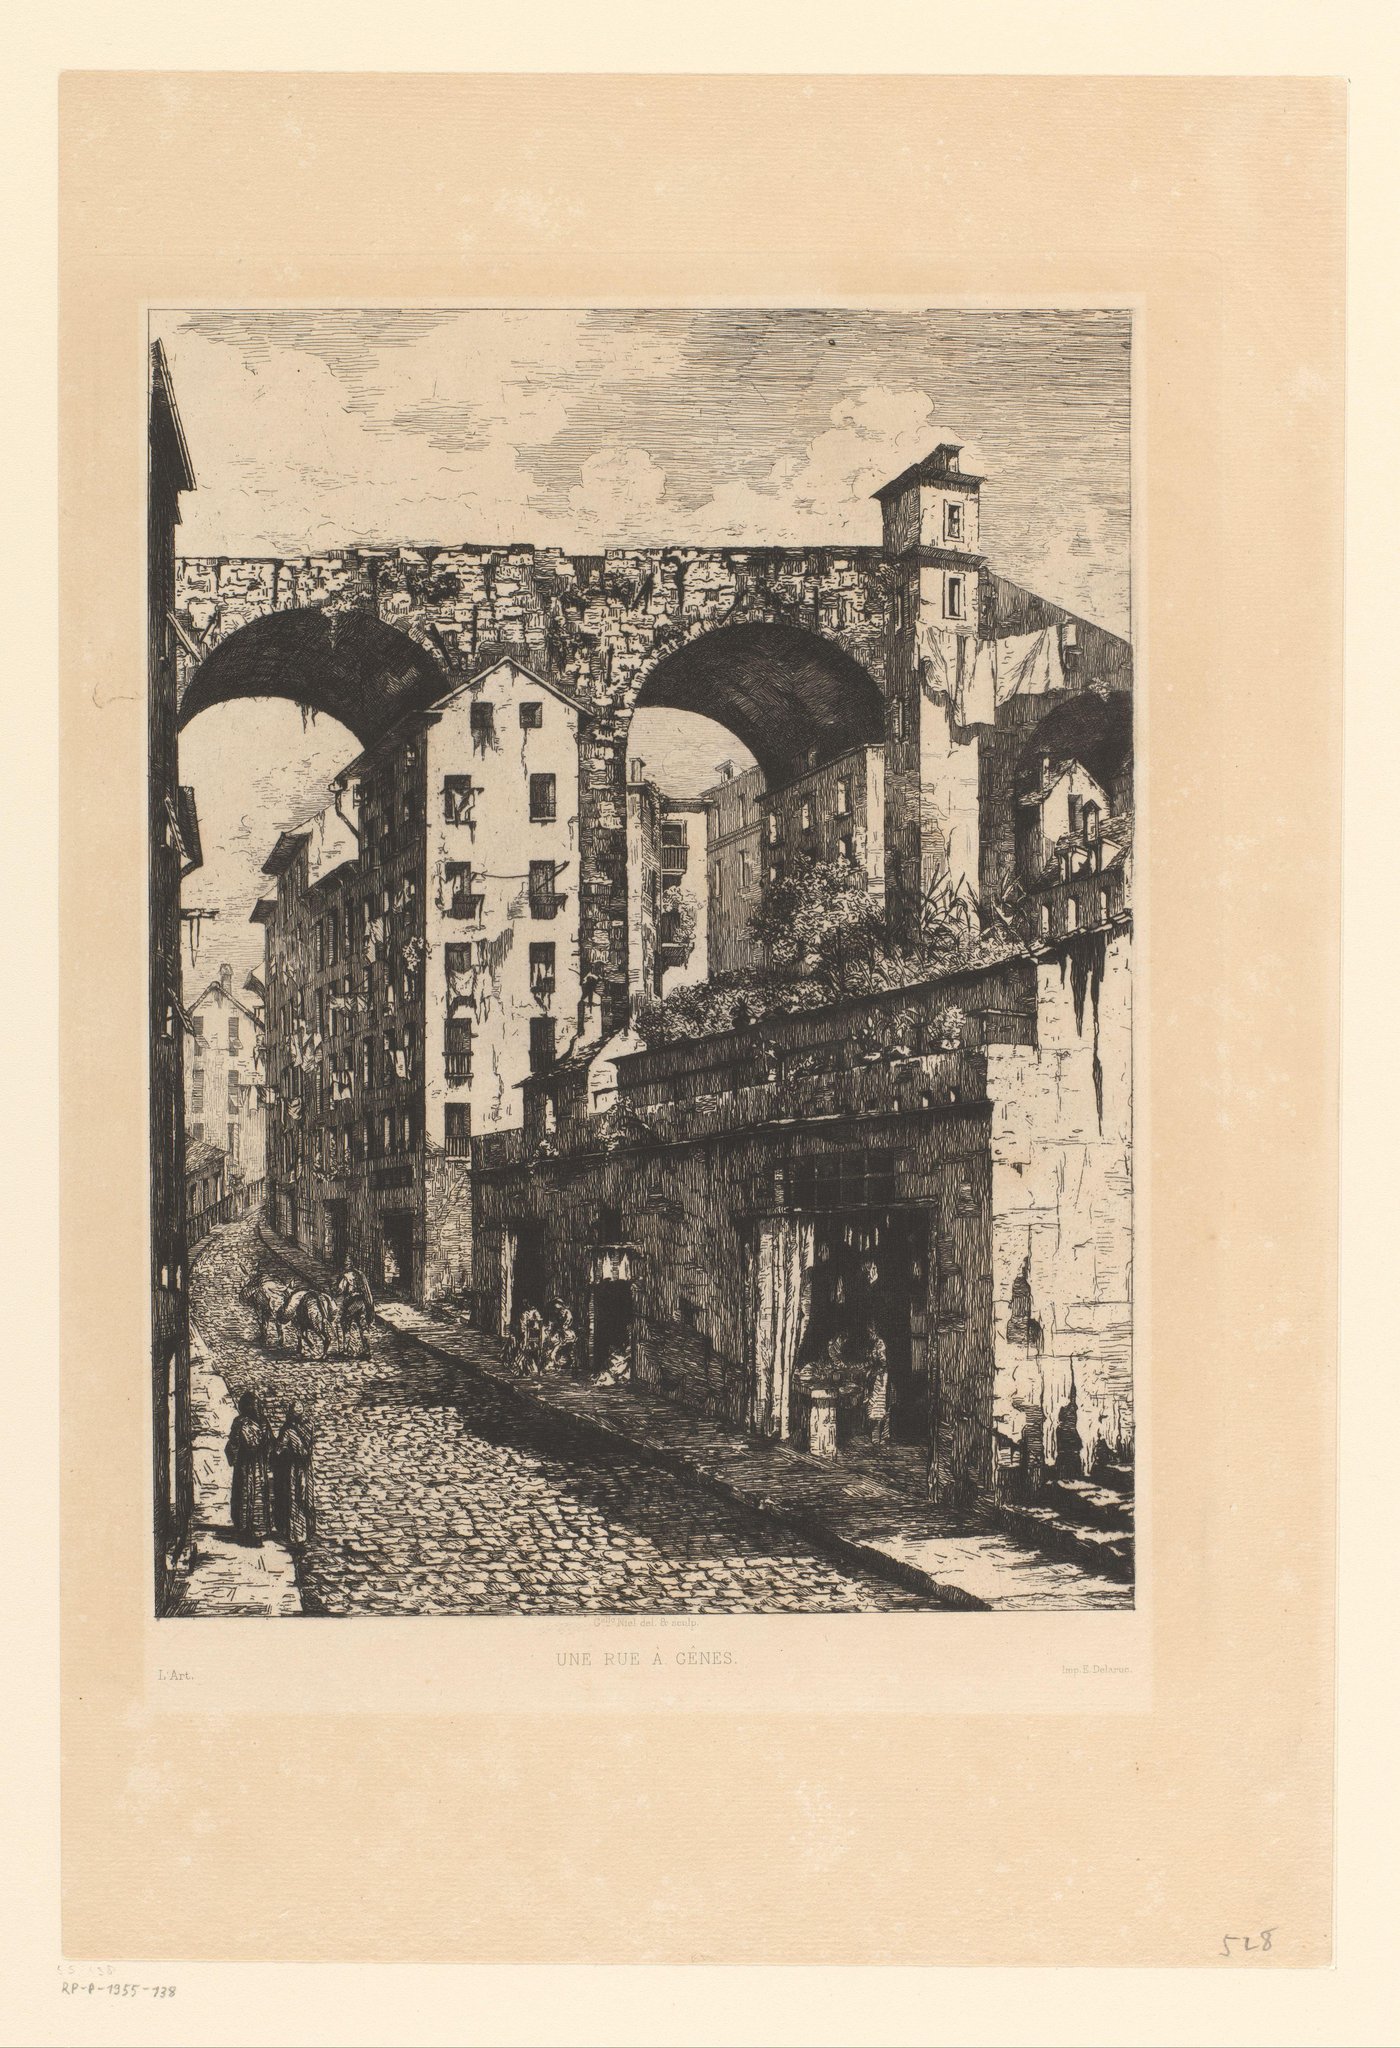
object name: print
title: Straatgezicht in Gênes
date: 1850-1940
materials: paper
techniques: drypoint, etching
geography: paris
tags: street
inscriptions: collector's mark: Lugt 2228